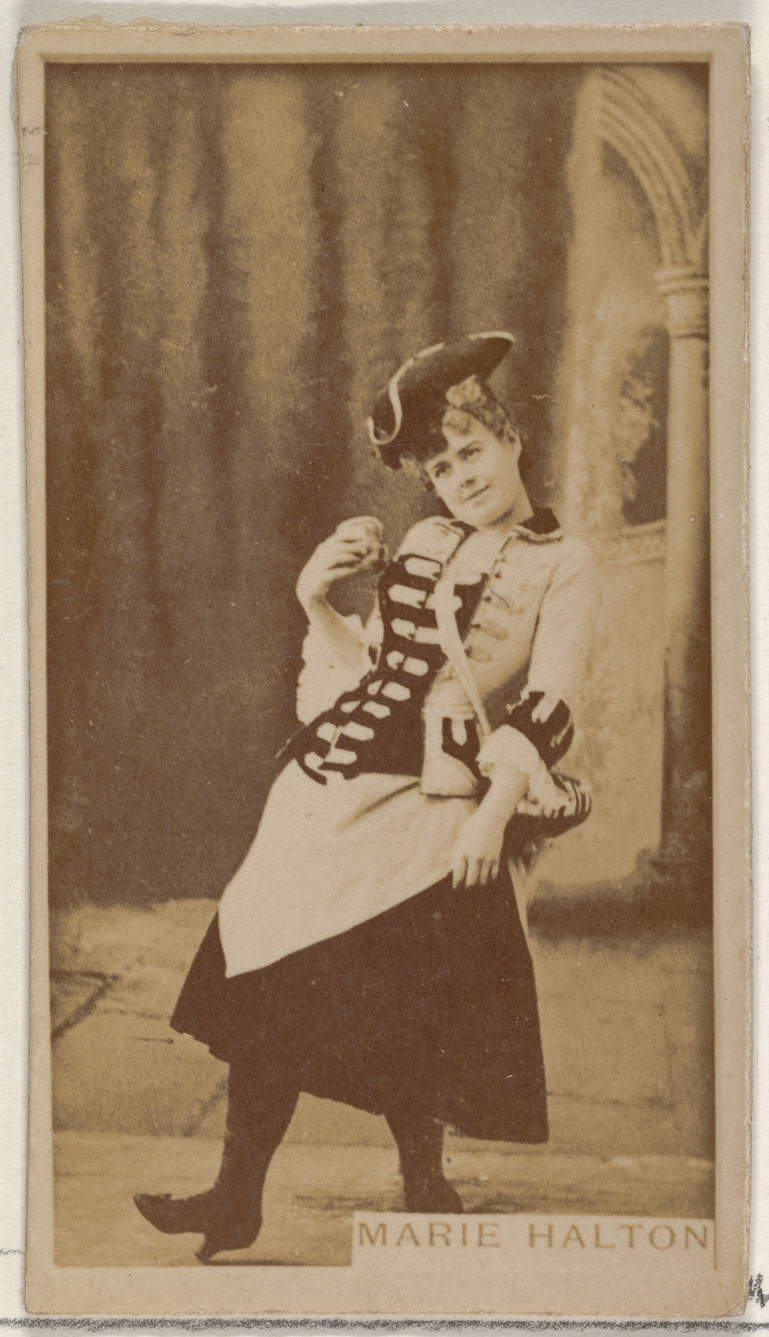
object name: photograph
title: Marie Halton, from the Actors and Actresses series (N45, Type 8) for Virginia Brights Cigarettes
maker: allen & ginter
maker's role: publisher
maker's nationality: american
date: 1888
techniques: albumen silver print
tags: portraits,women,actresses